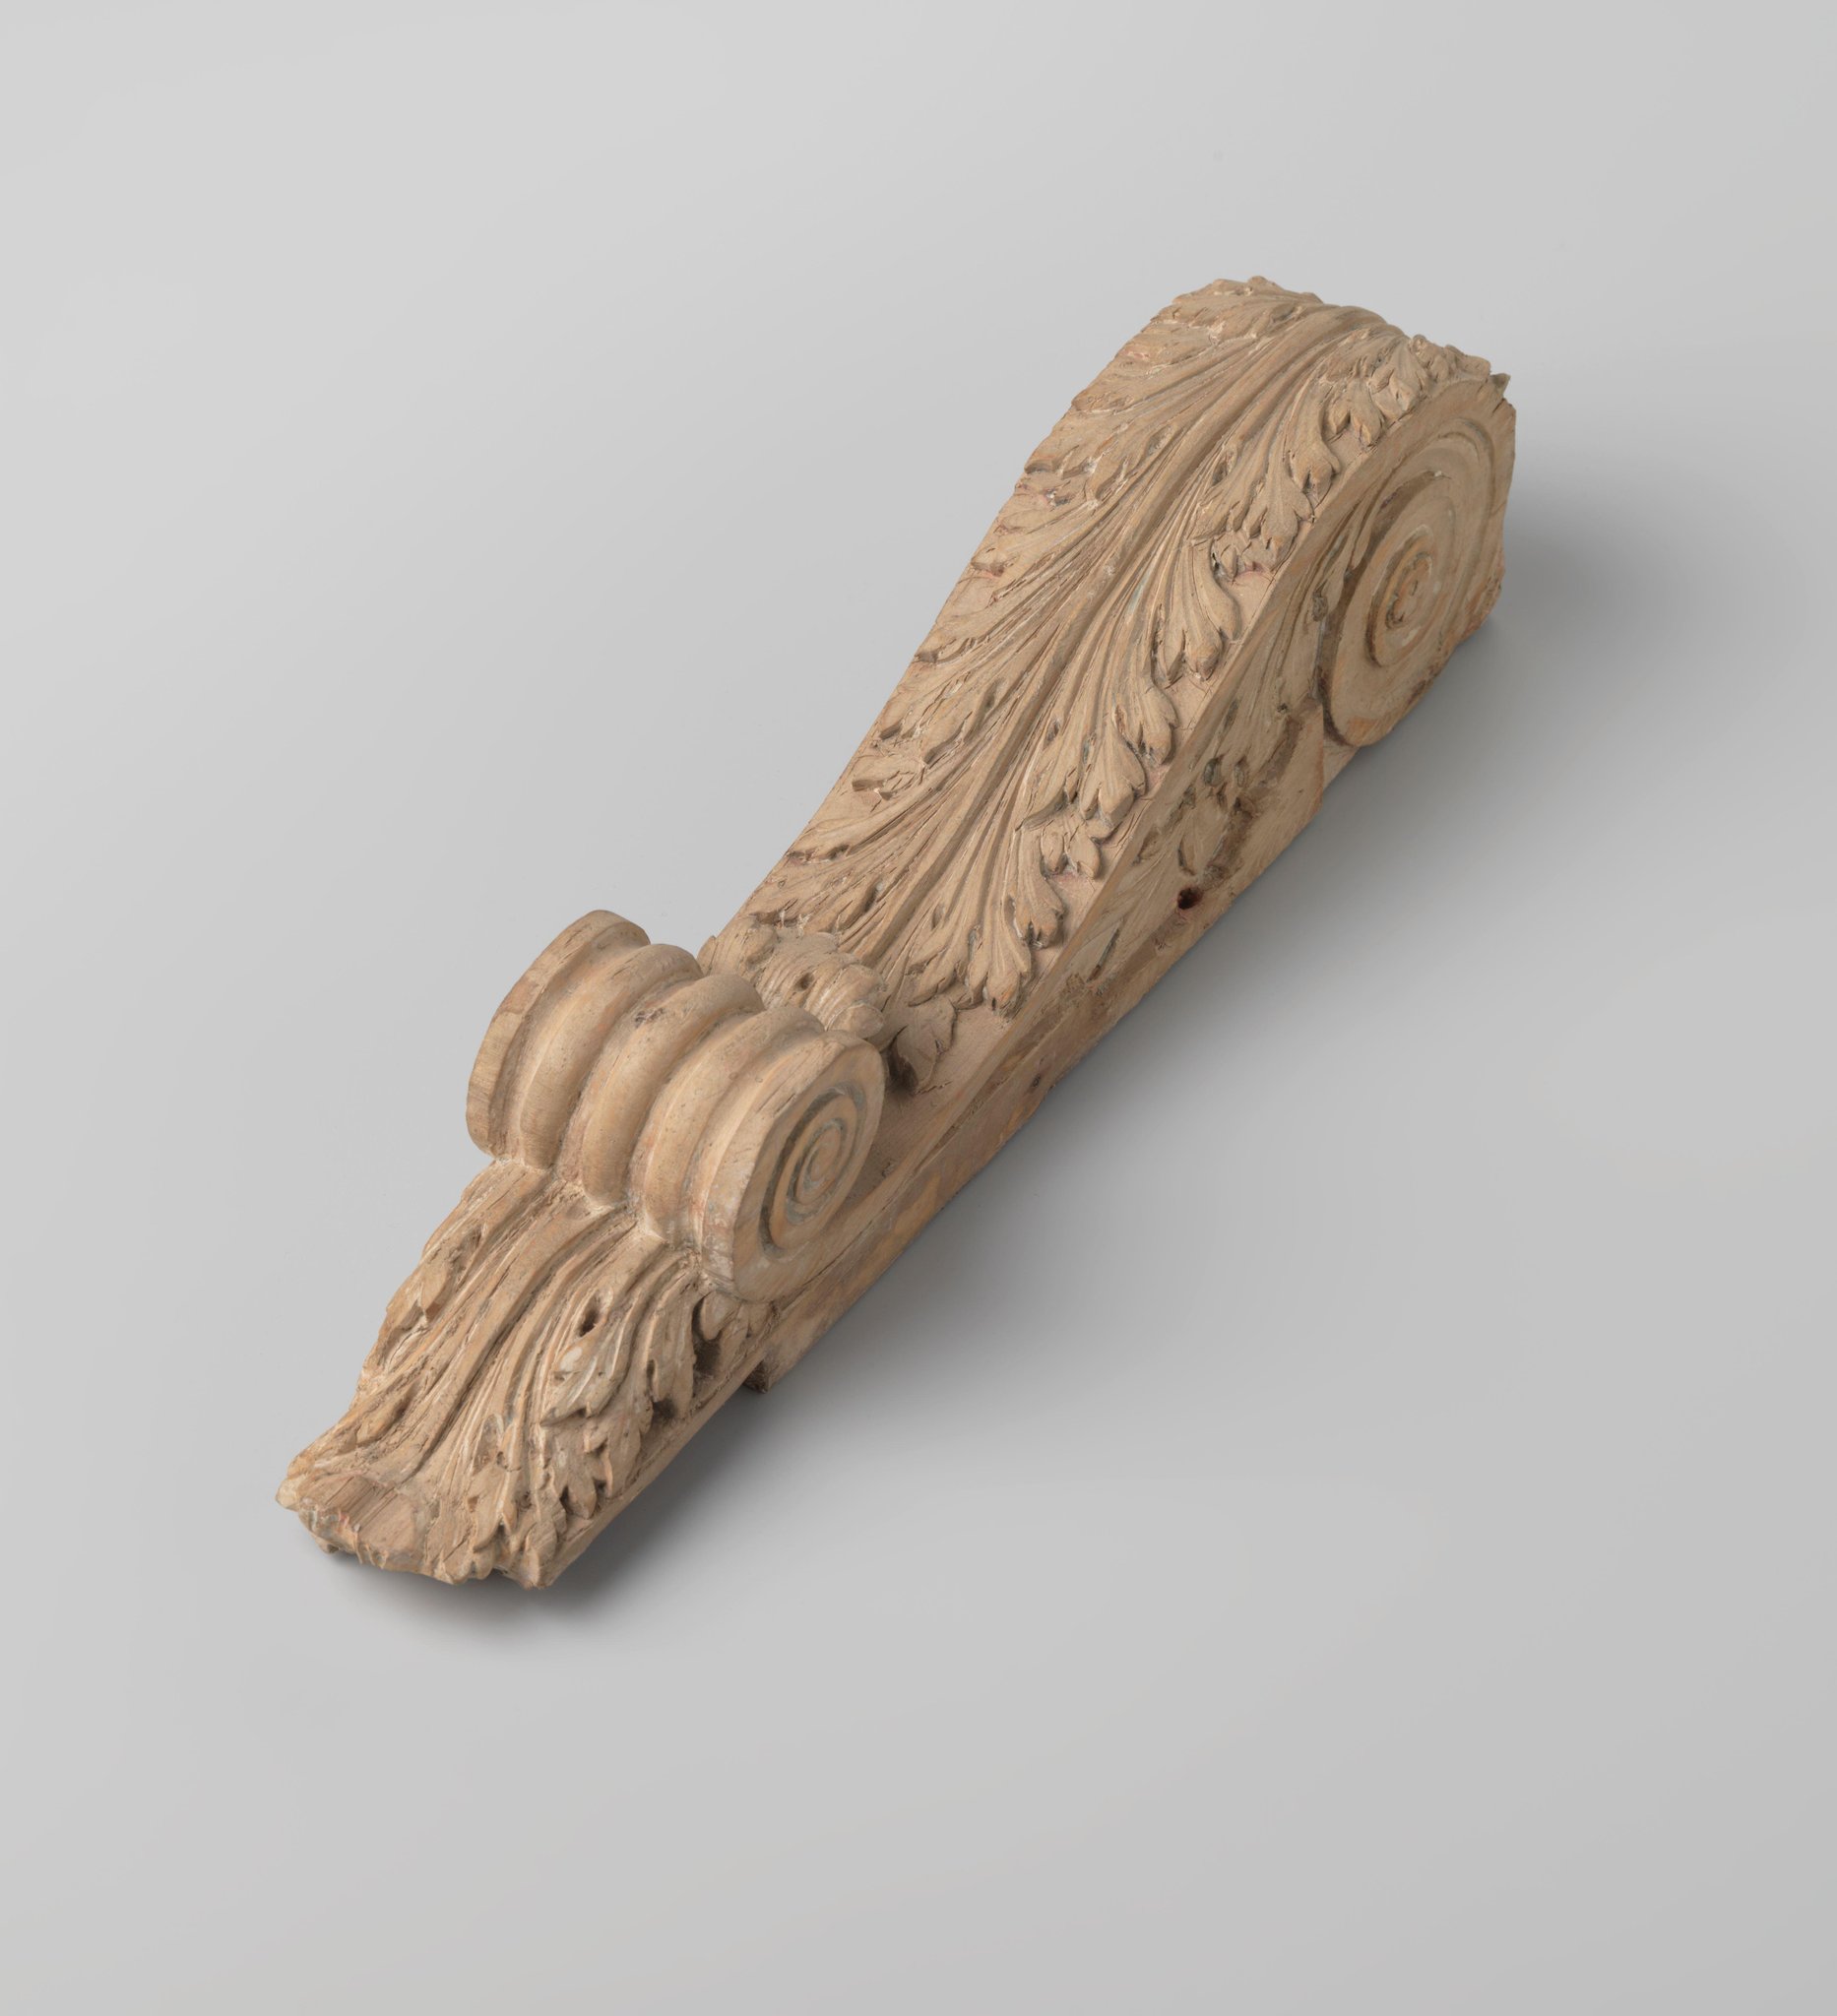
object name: portiek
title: S-voluut behorend bij een portiek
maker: Anonymous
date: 1687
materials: wood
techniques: painted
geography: northern netherlands